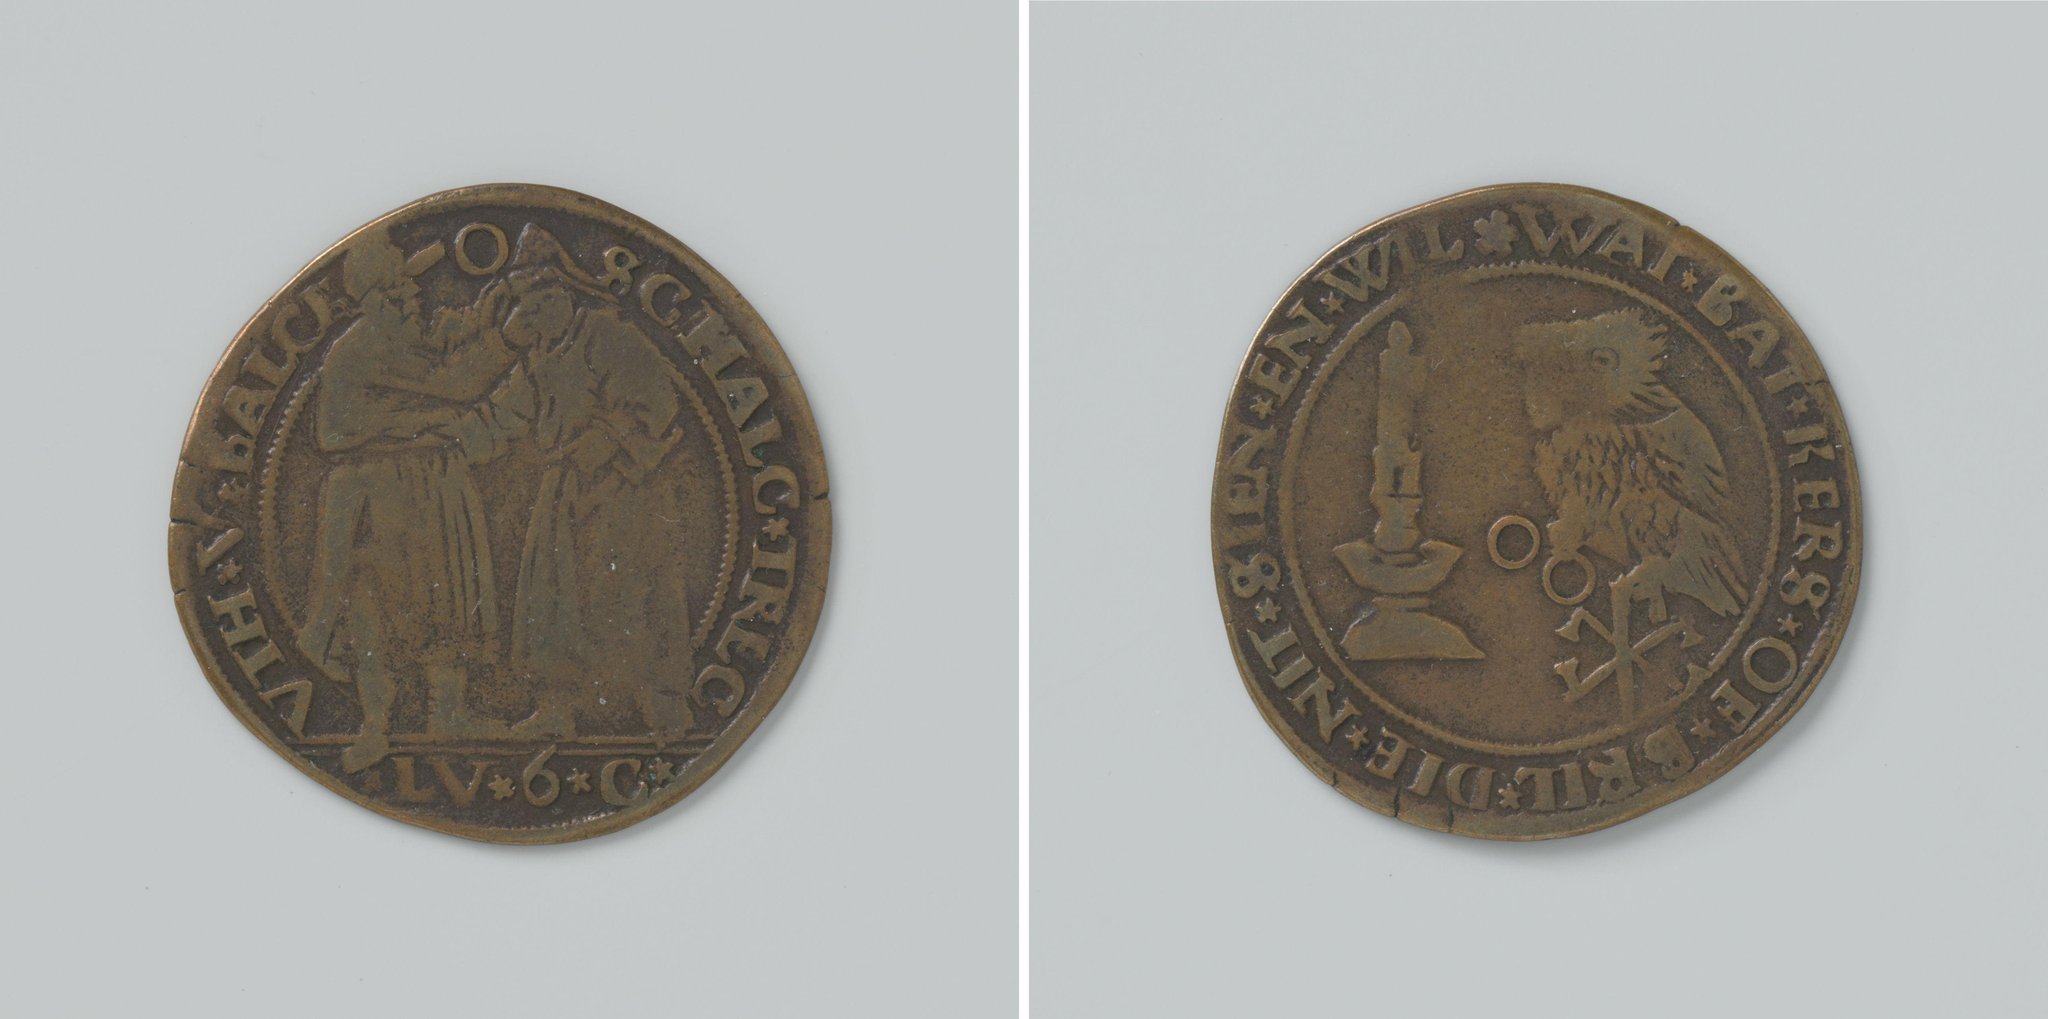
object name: jeton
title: Conflict tussen Calvijn en Servet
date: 1553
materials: copper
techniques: striking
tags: medicus, michael servet, noyon, genève, theoloog, hervormer, johannes calvijn, reformatie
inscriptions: circumscription: ‘WAT.BAT.KERS.OF.BRIL.DIE.NIET.SIEN.EN.WIL’, circumscription: ‘CHALCK TREC / LV.6.C / VTH.V.BALCK’